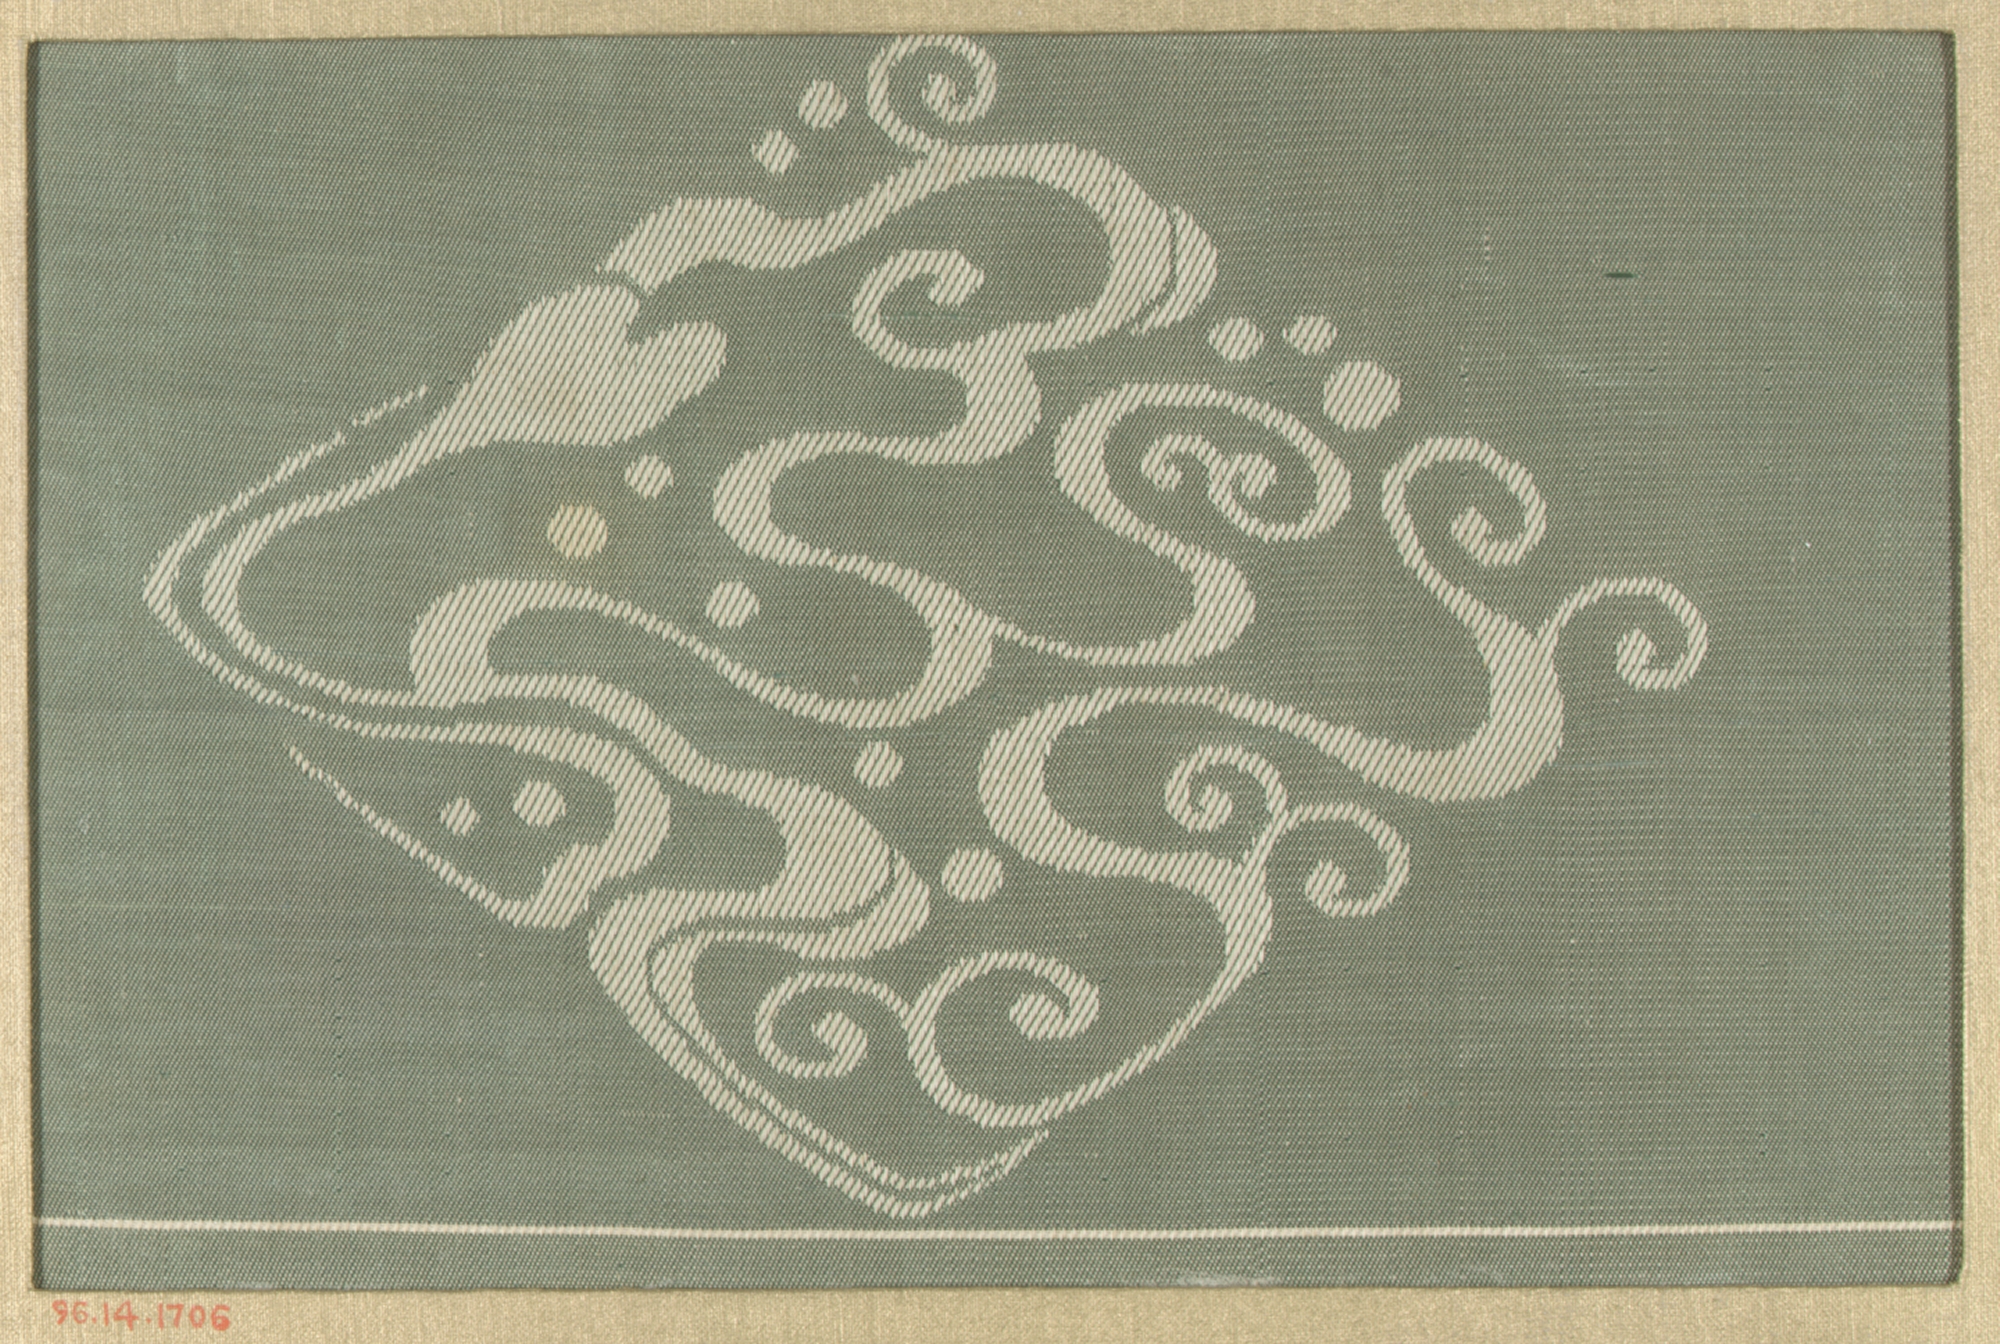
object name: piece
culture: japanese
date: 1701-1800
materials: silk